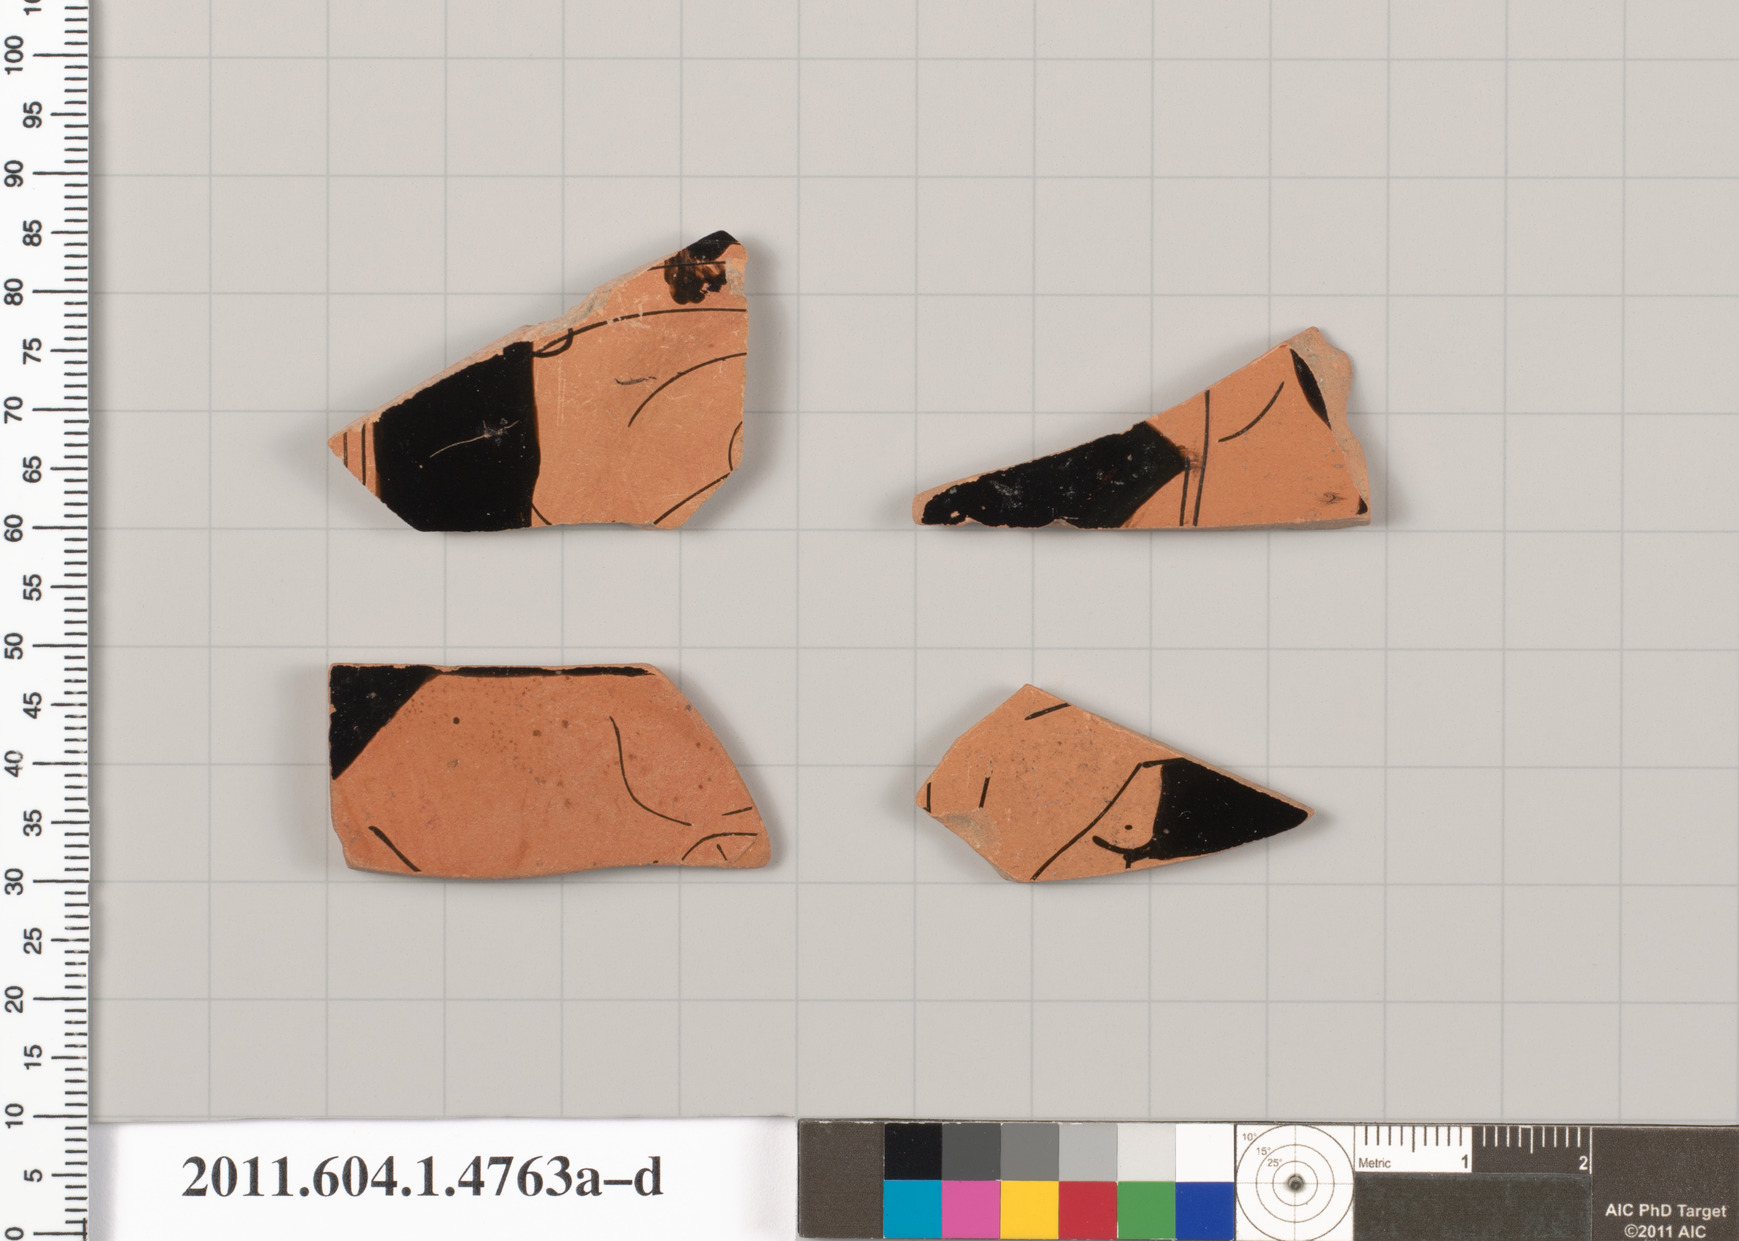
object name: kylix fragment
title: Terracotta fragments of kylikes (drinking cups)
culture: greek, attic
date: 475-451 BCE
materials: terracotta